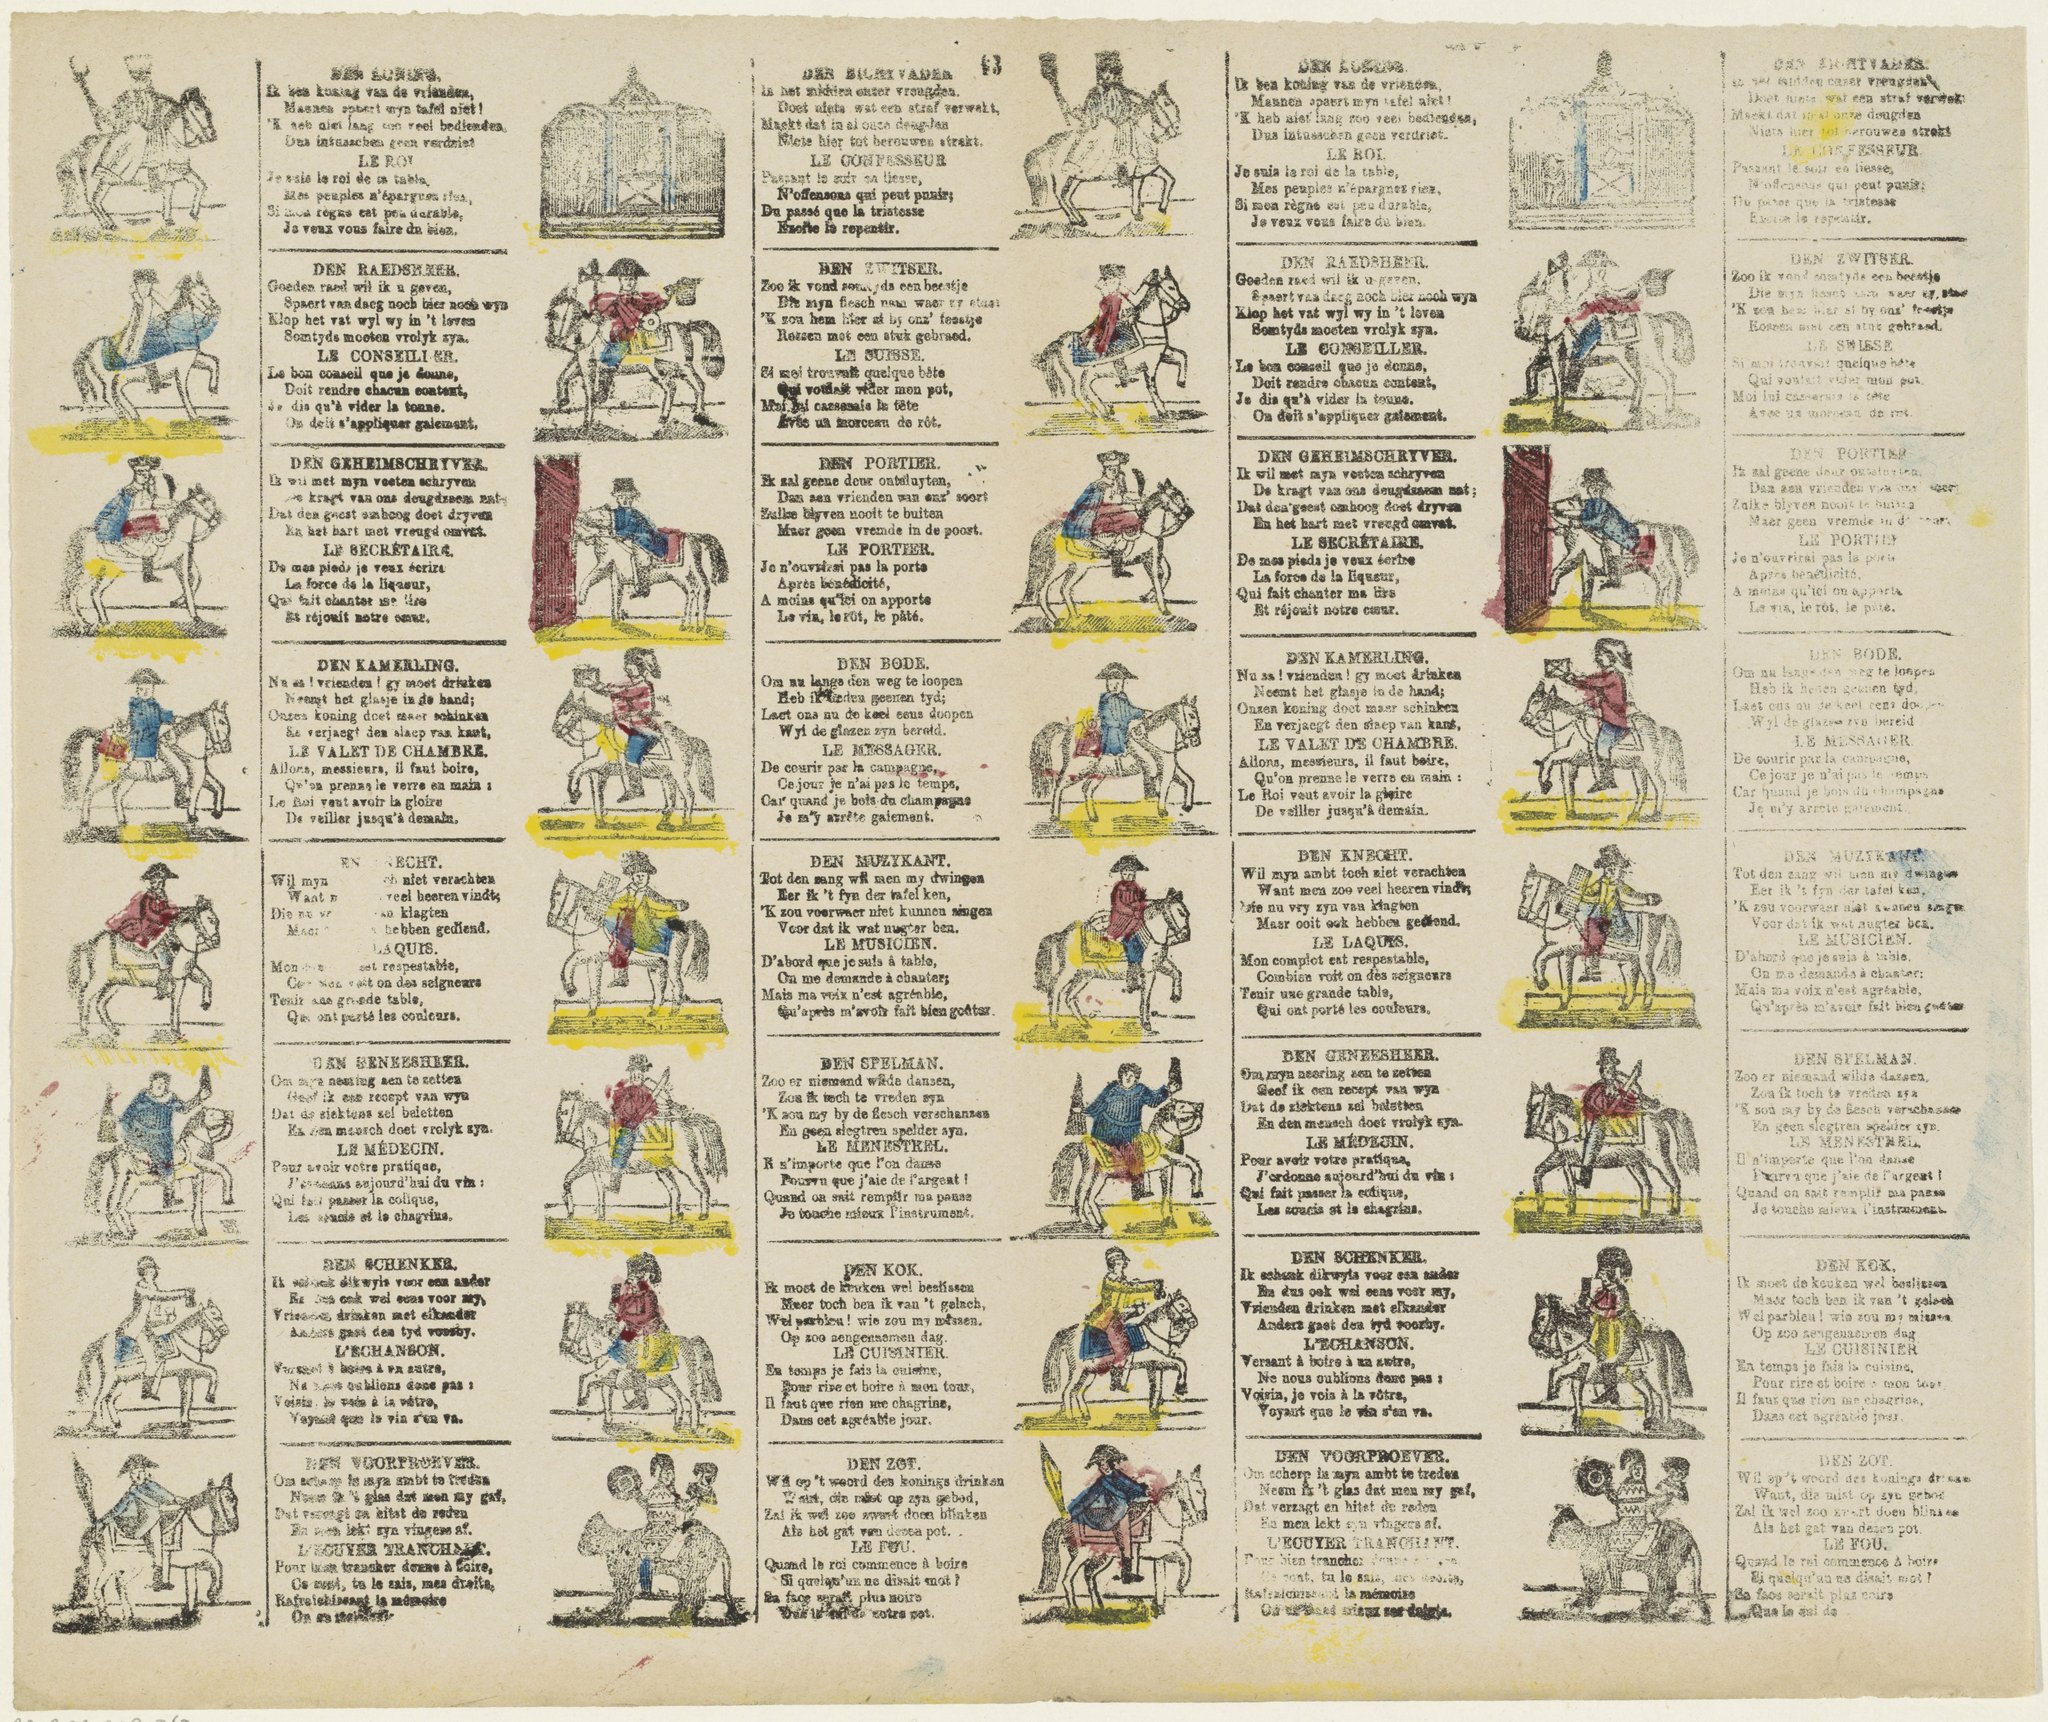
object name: print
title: Driekoningenbriefjes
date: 1827-1894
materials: paper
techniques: colour, letterpress printing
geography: schaarbeek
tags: twelfth night, usually falling on the eve of january 6, royal household; courtiers, retinue, train, epiphany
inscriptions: collector's mark: Lugt 2760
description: Blad met 32 voorstellingen (driekoningenbriefjes) van verschillende functies binnen het hof, waaronder een raadsman, een proever en een portier. Rechts naast elke afbeelding een vierregelig vers in het Nederlands en in het Frans. Genummerd midden boven: 43.